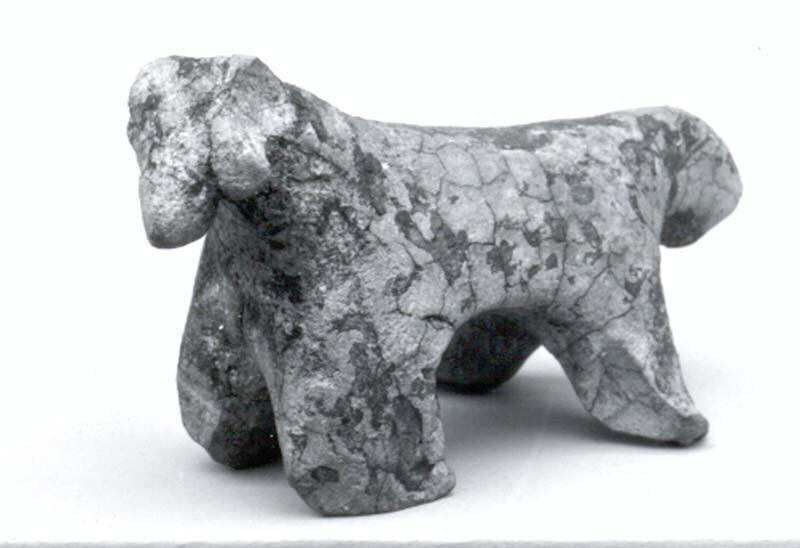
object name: sculpture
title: Animal figurine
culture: sasanian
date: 201-700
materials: ceramic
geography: iran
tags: animals